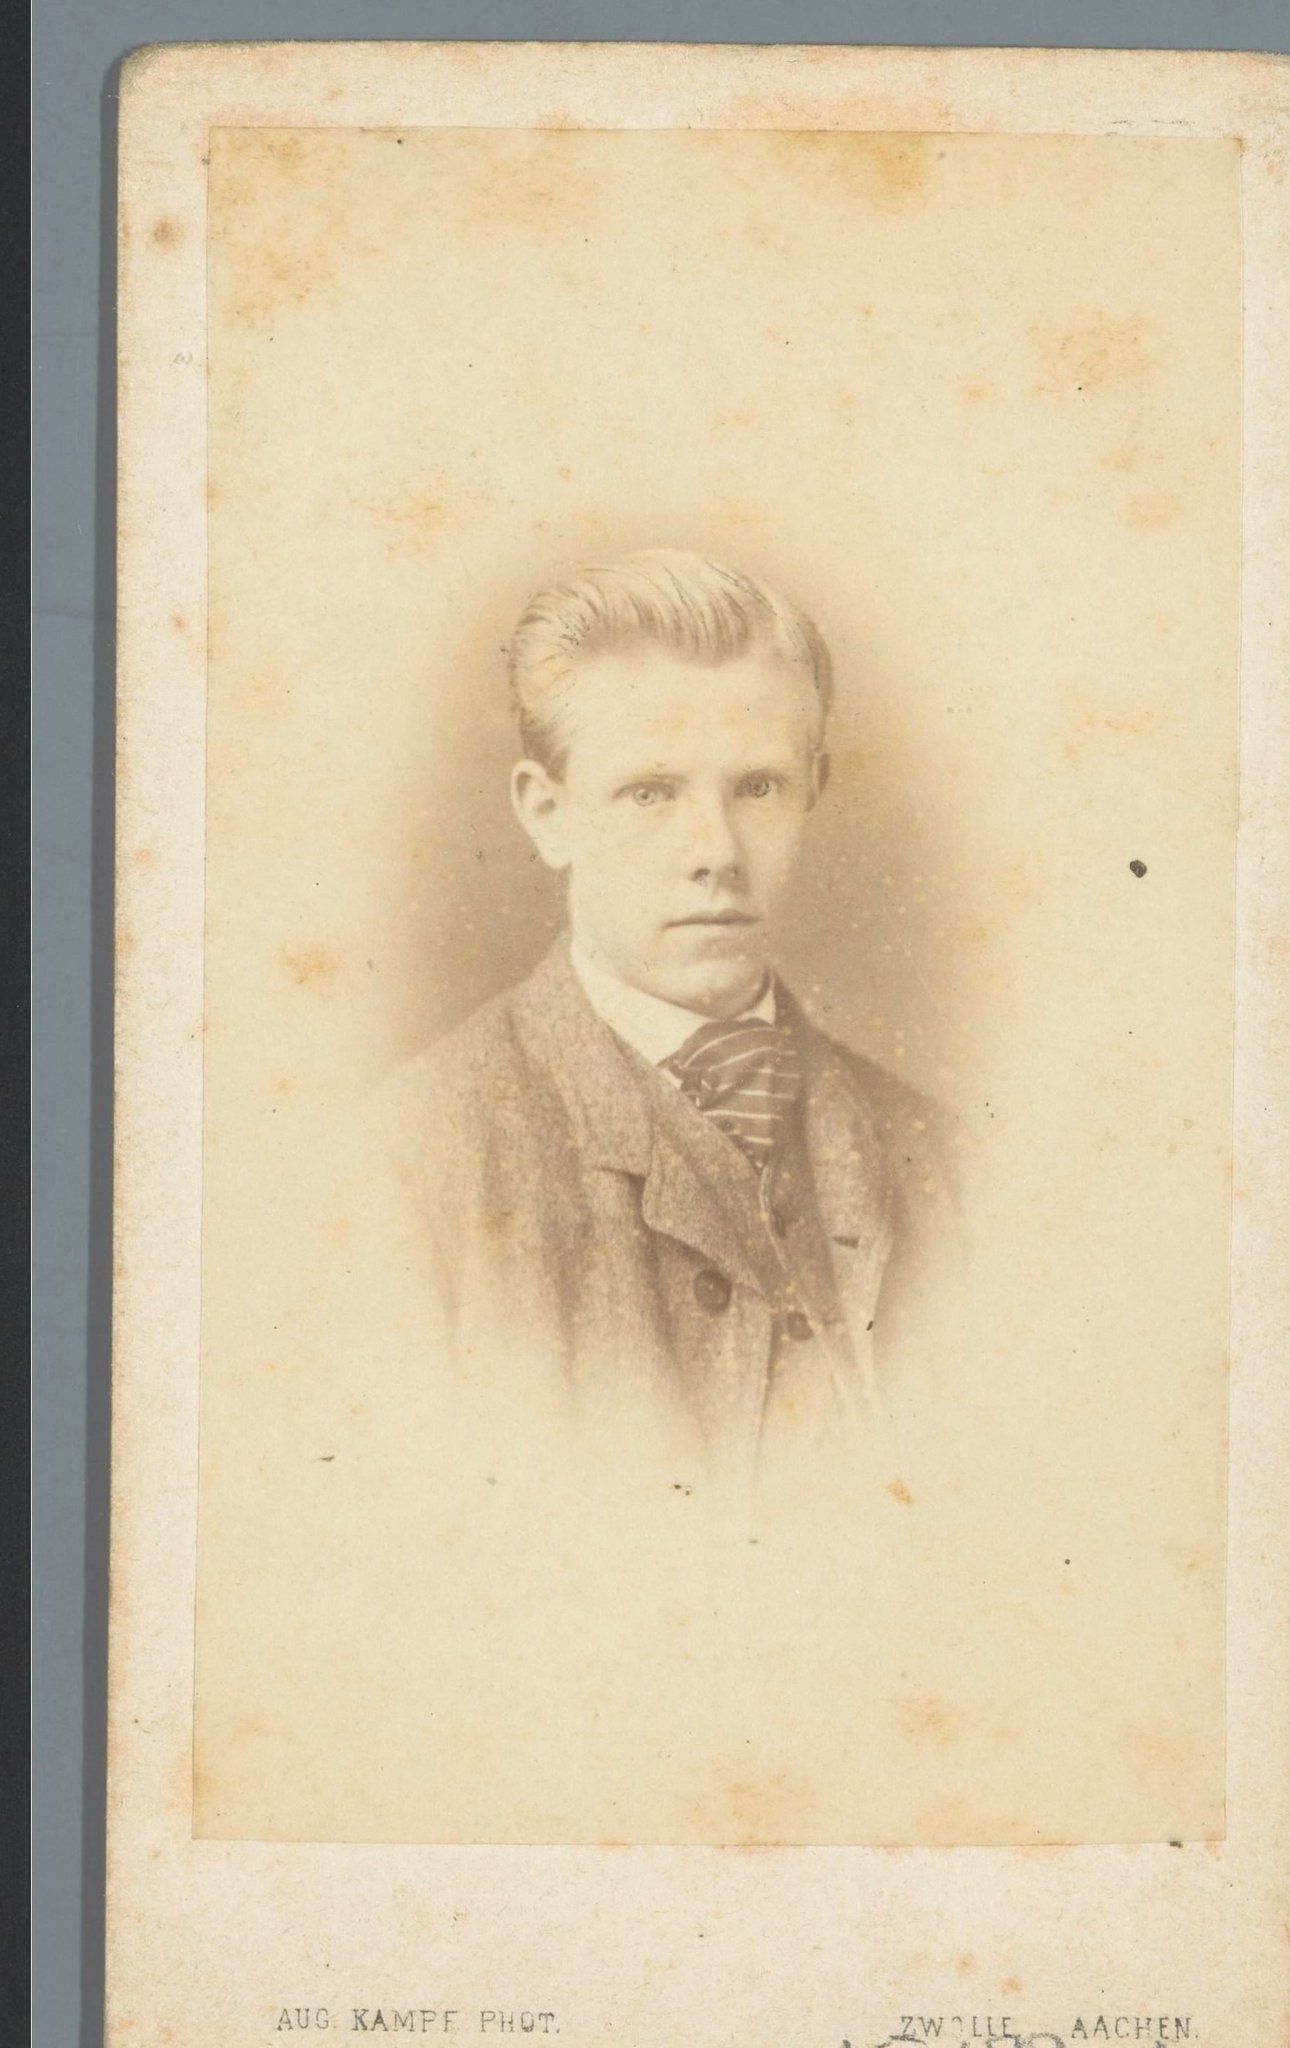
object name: photograph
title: Portret van een onbekende man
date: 1866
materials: cardboard, paper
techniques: albumen print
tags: historical persons, youth, adolescent